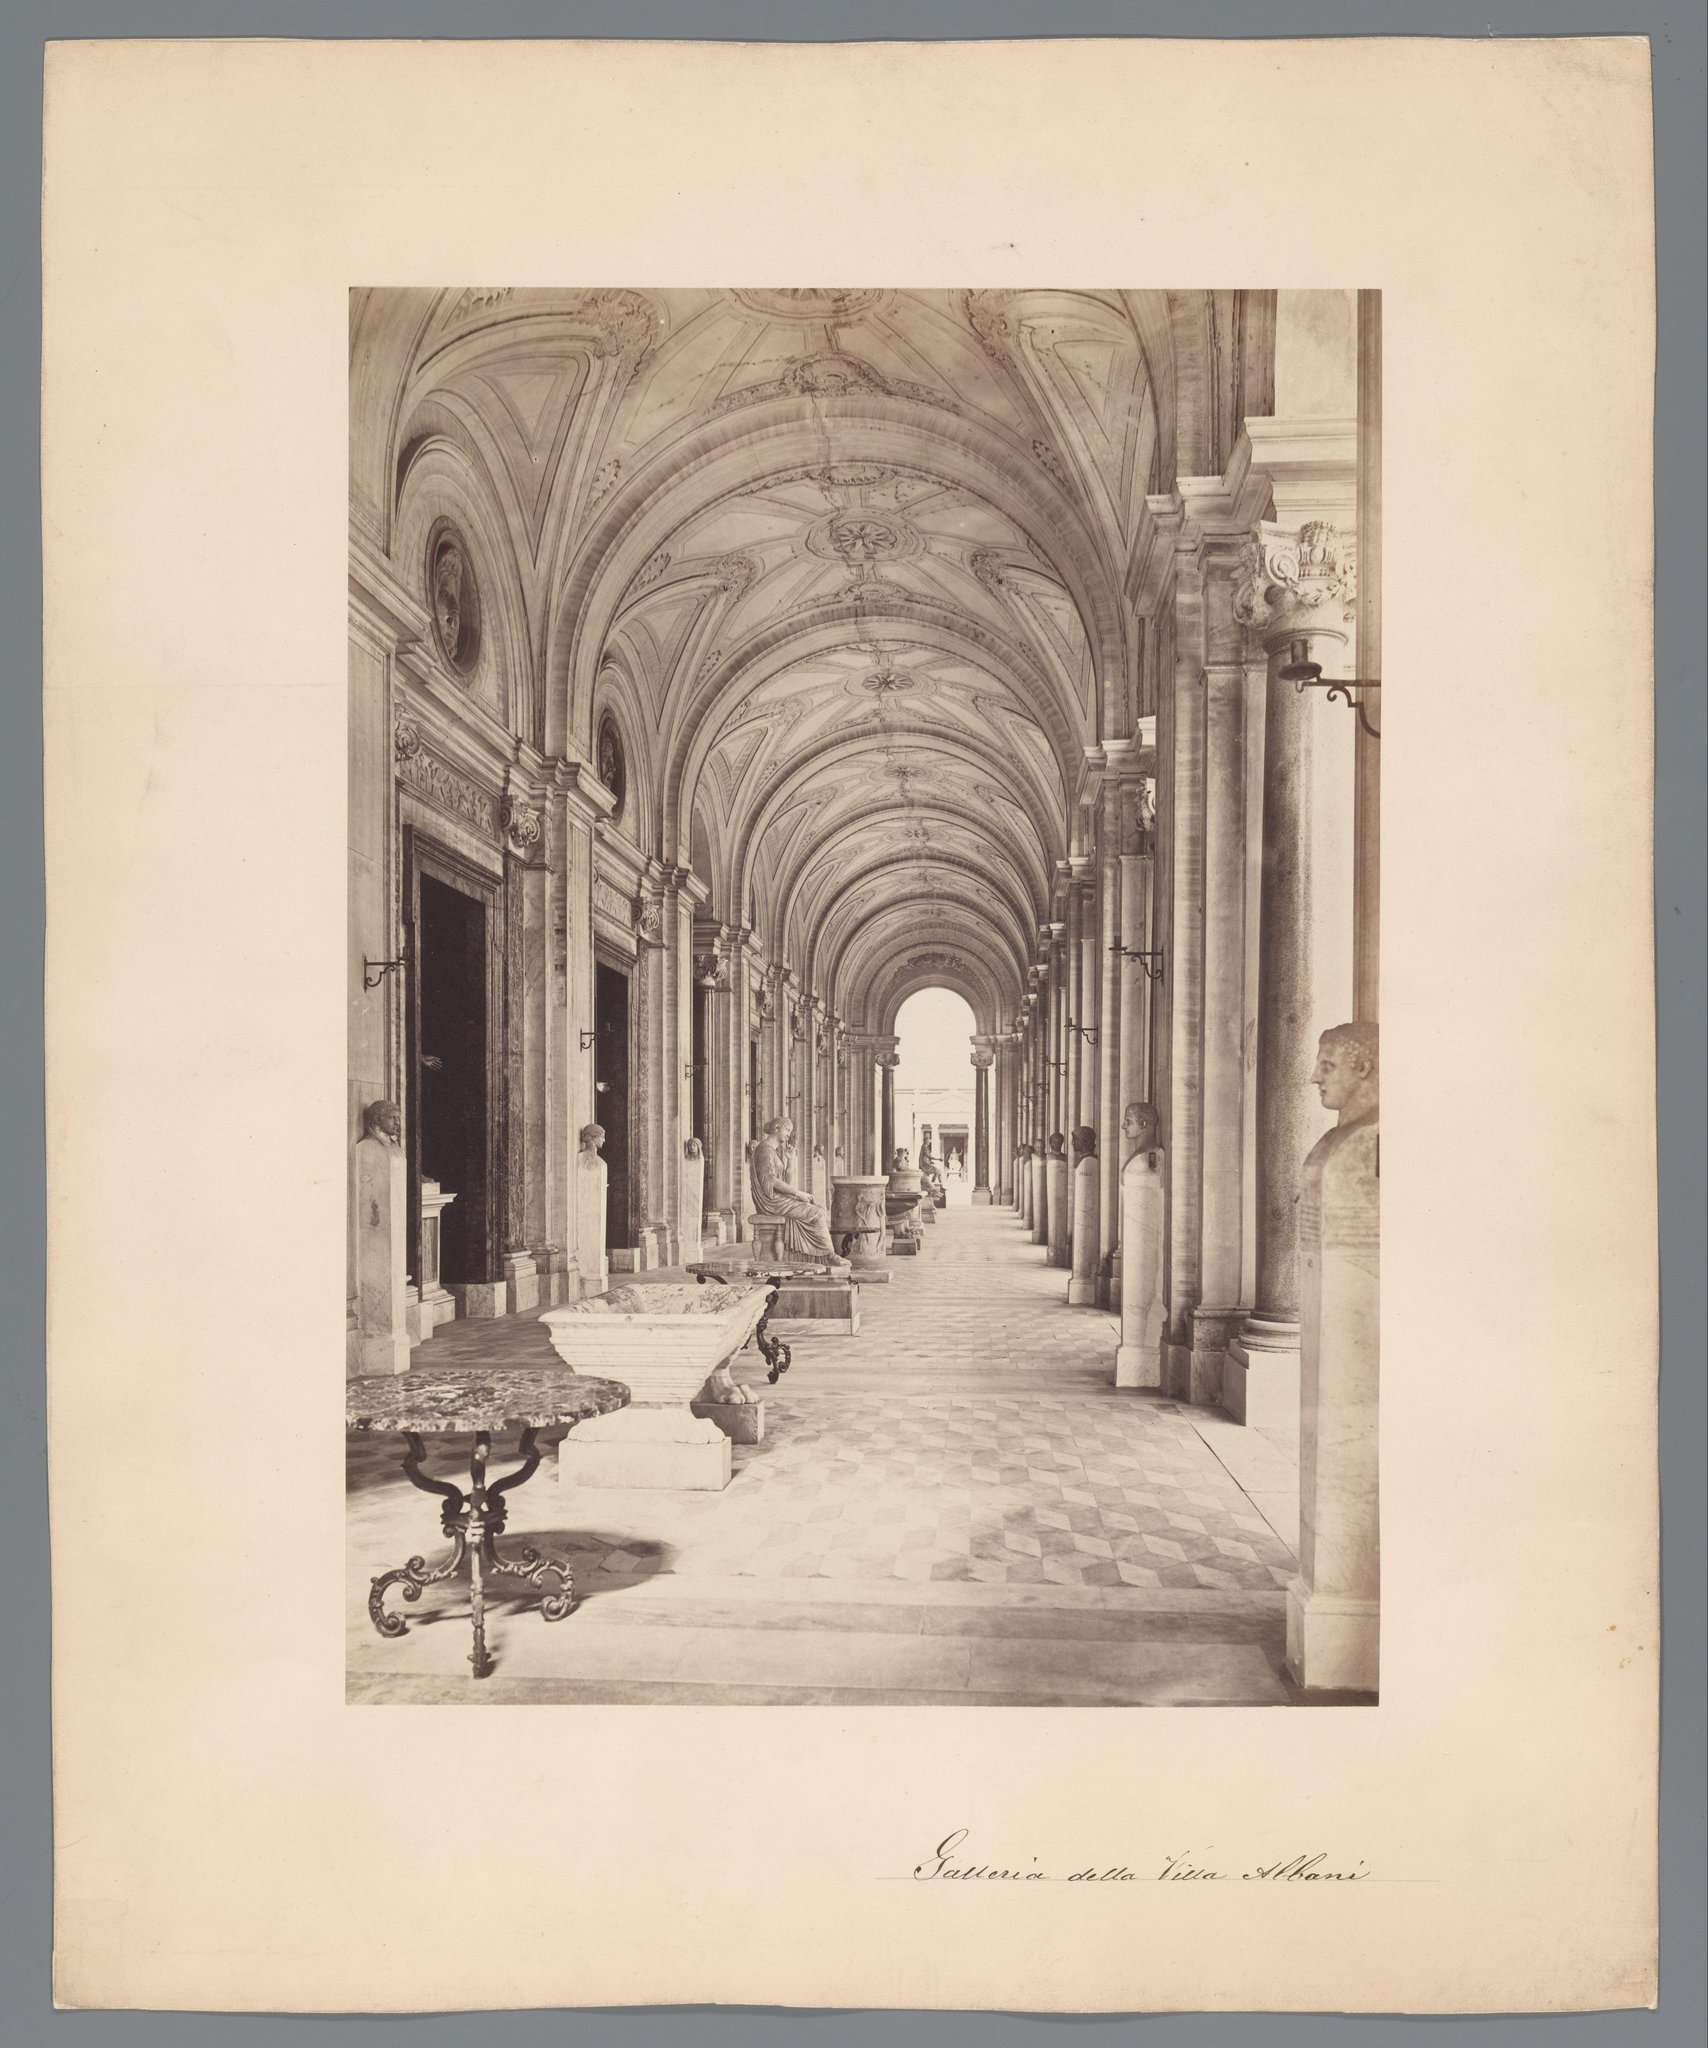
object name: photograph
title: Gezicht op de galerij van de Villa Albani te Rome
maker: Anonymous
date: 1851-1880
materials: cardboard, paper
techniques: albumen print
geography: rome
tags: gallery of sculptures, gallery (spacious corridor)